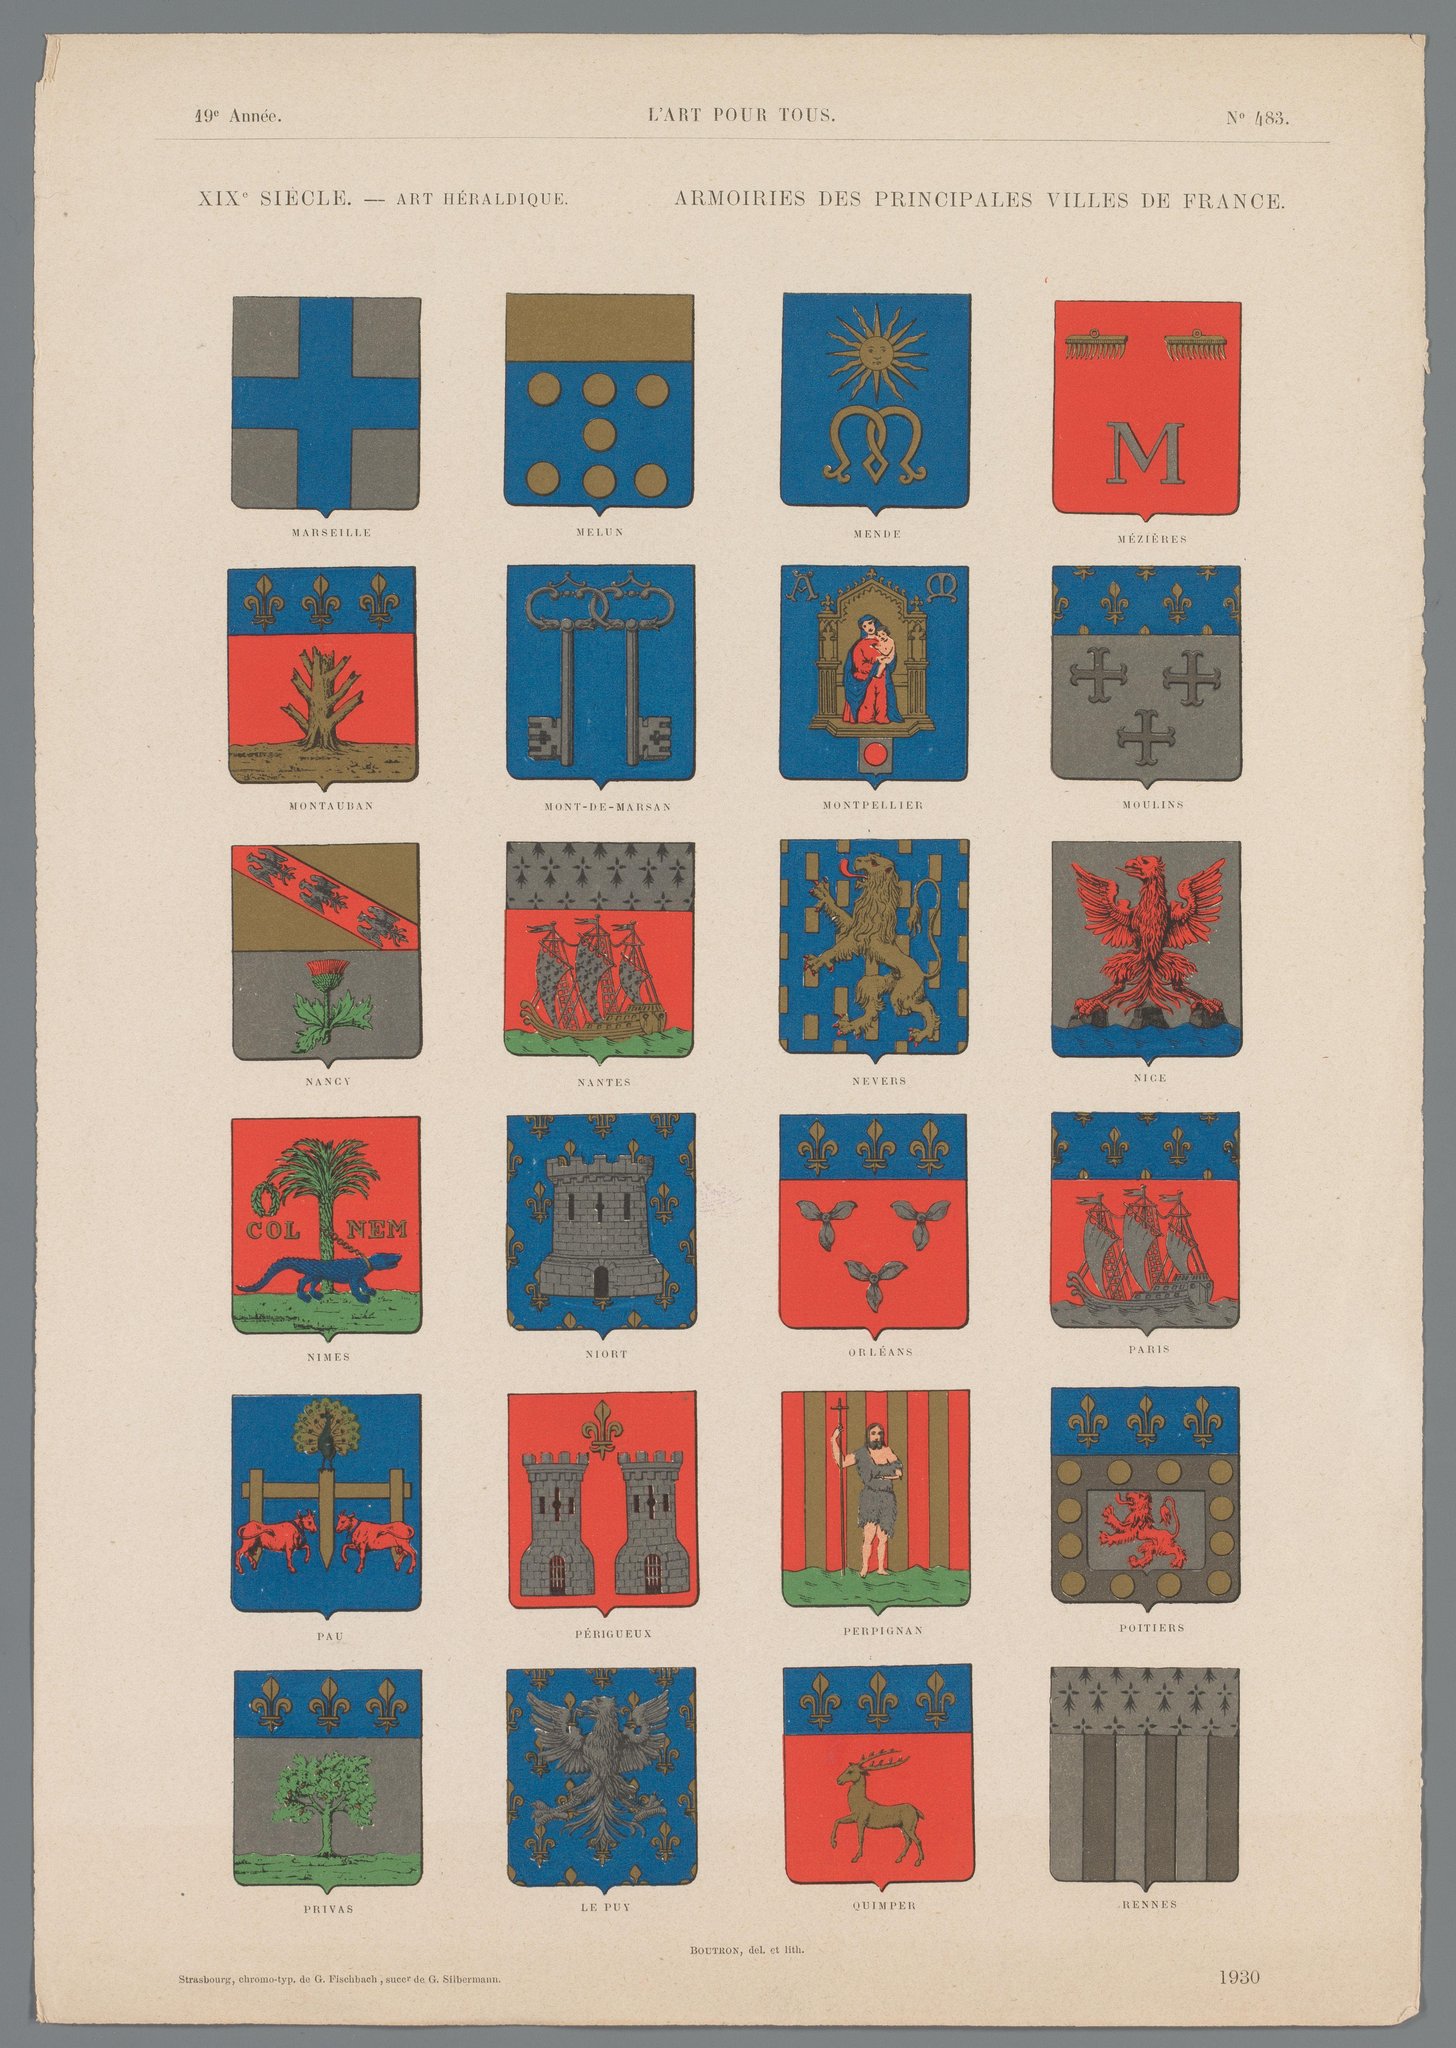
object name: print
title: Vierentwintig wapenschilden van Franse steden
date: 1880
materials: paper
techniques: chromolithography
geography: straatsburg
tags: armorial bearing, heraldry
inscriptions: collector's mark: Lugt 3937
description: Prent uit: L'Art pour tous 19 (1880), nr. 483, 31 juli 1880.